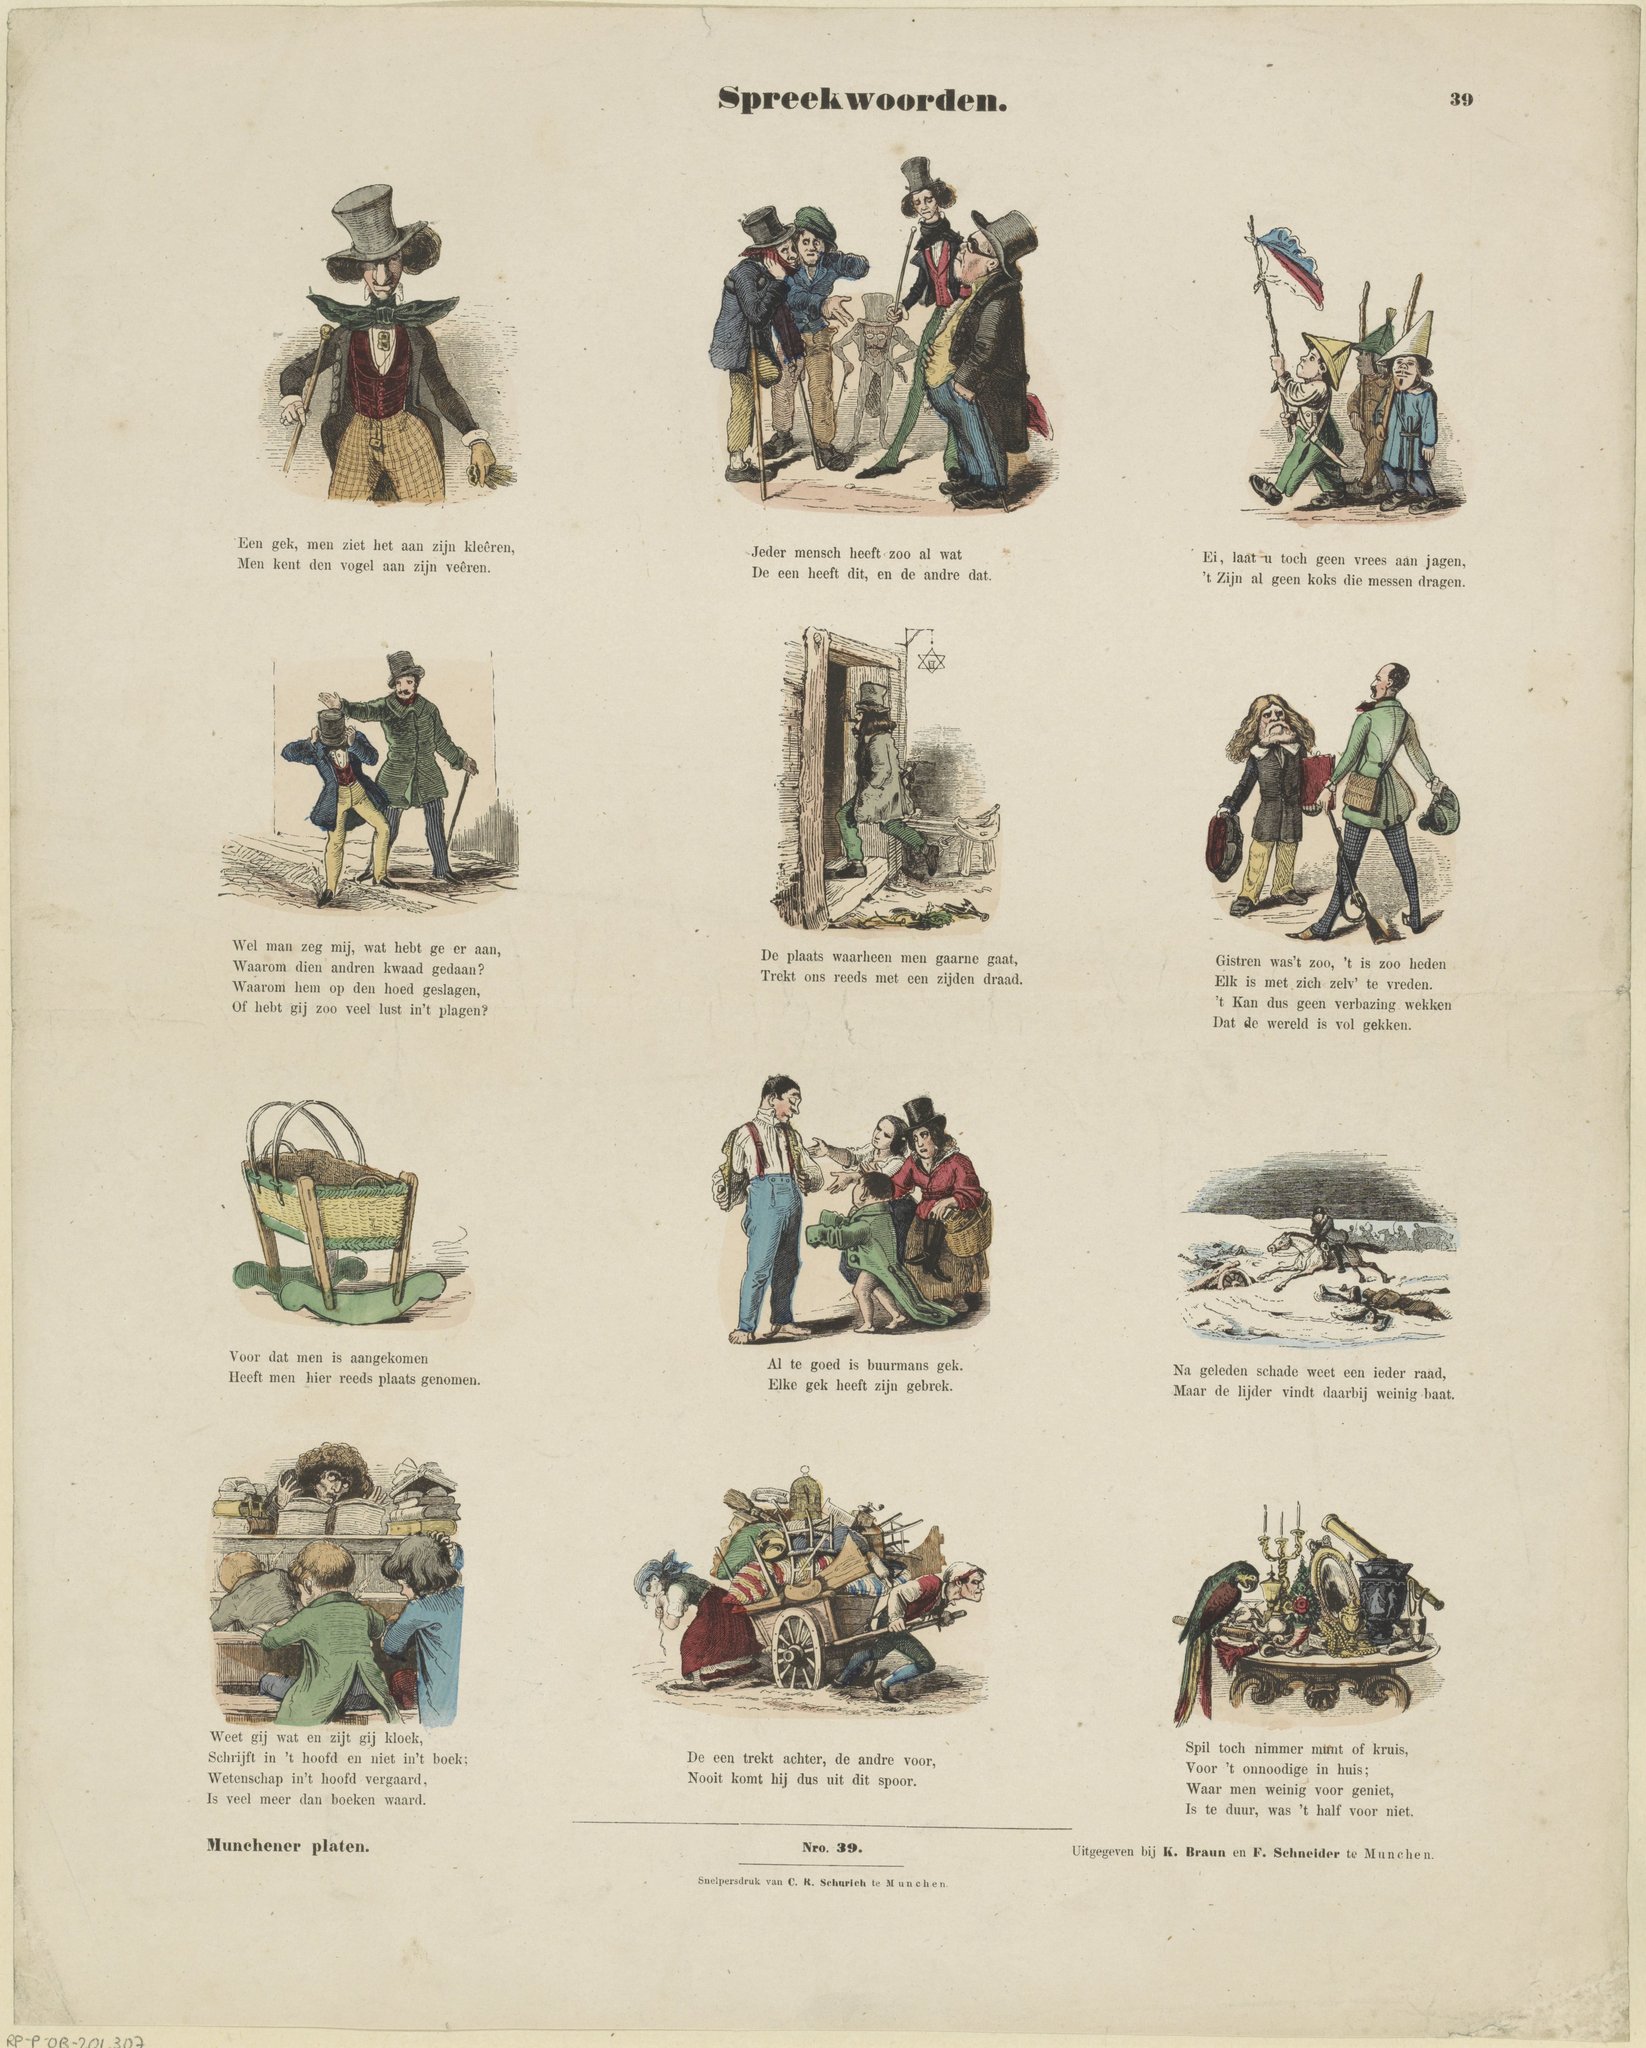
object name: popular print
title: Munchener platen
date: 1843-1920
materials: paper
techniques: colour, letterpress printing, engraving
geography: munich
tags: proverbs, sayings, etc.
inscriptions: collector's mark: Lugt 2760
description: Blad met 12 verbeeldingen van spreekwoorden. Onder elke afbeelding het spreekwoord. Genummerd midden onder: Nro. 39. Genummerd rechtsboven: 39.